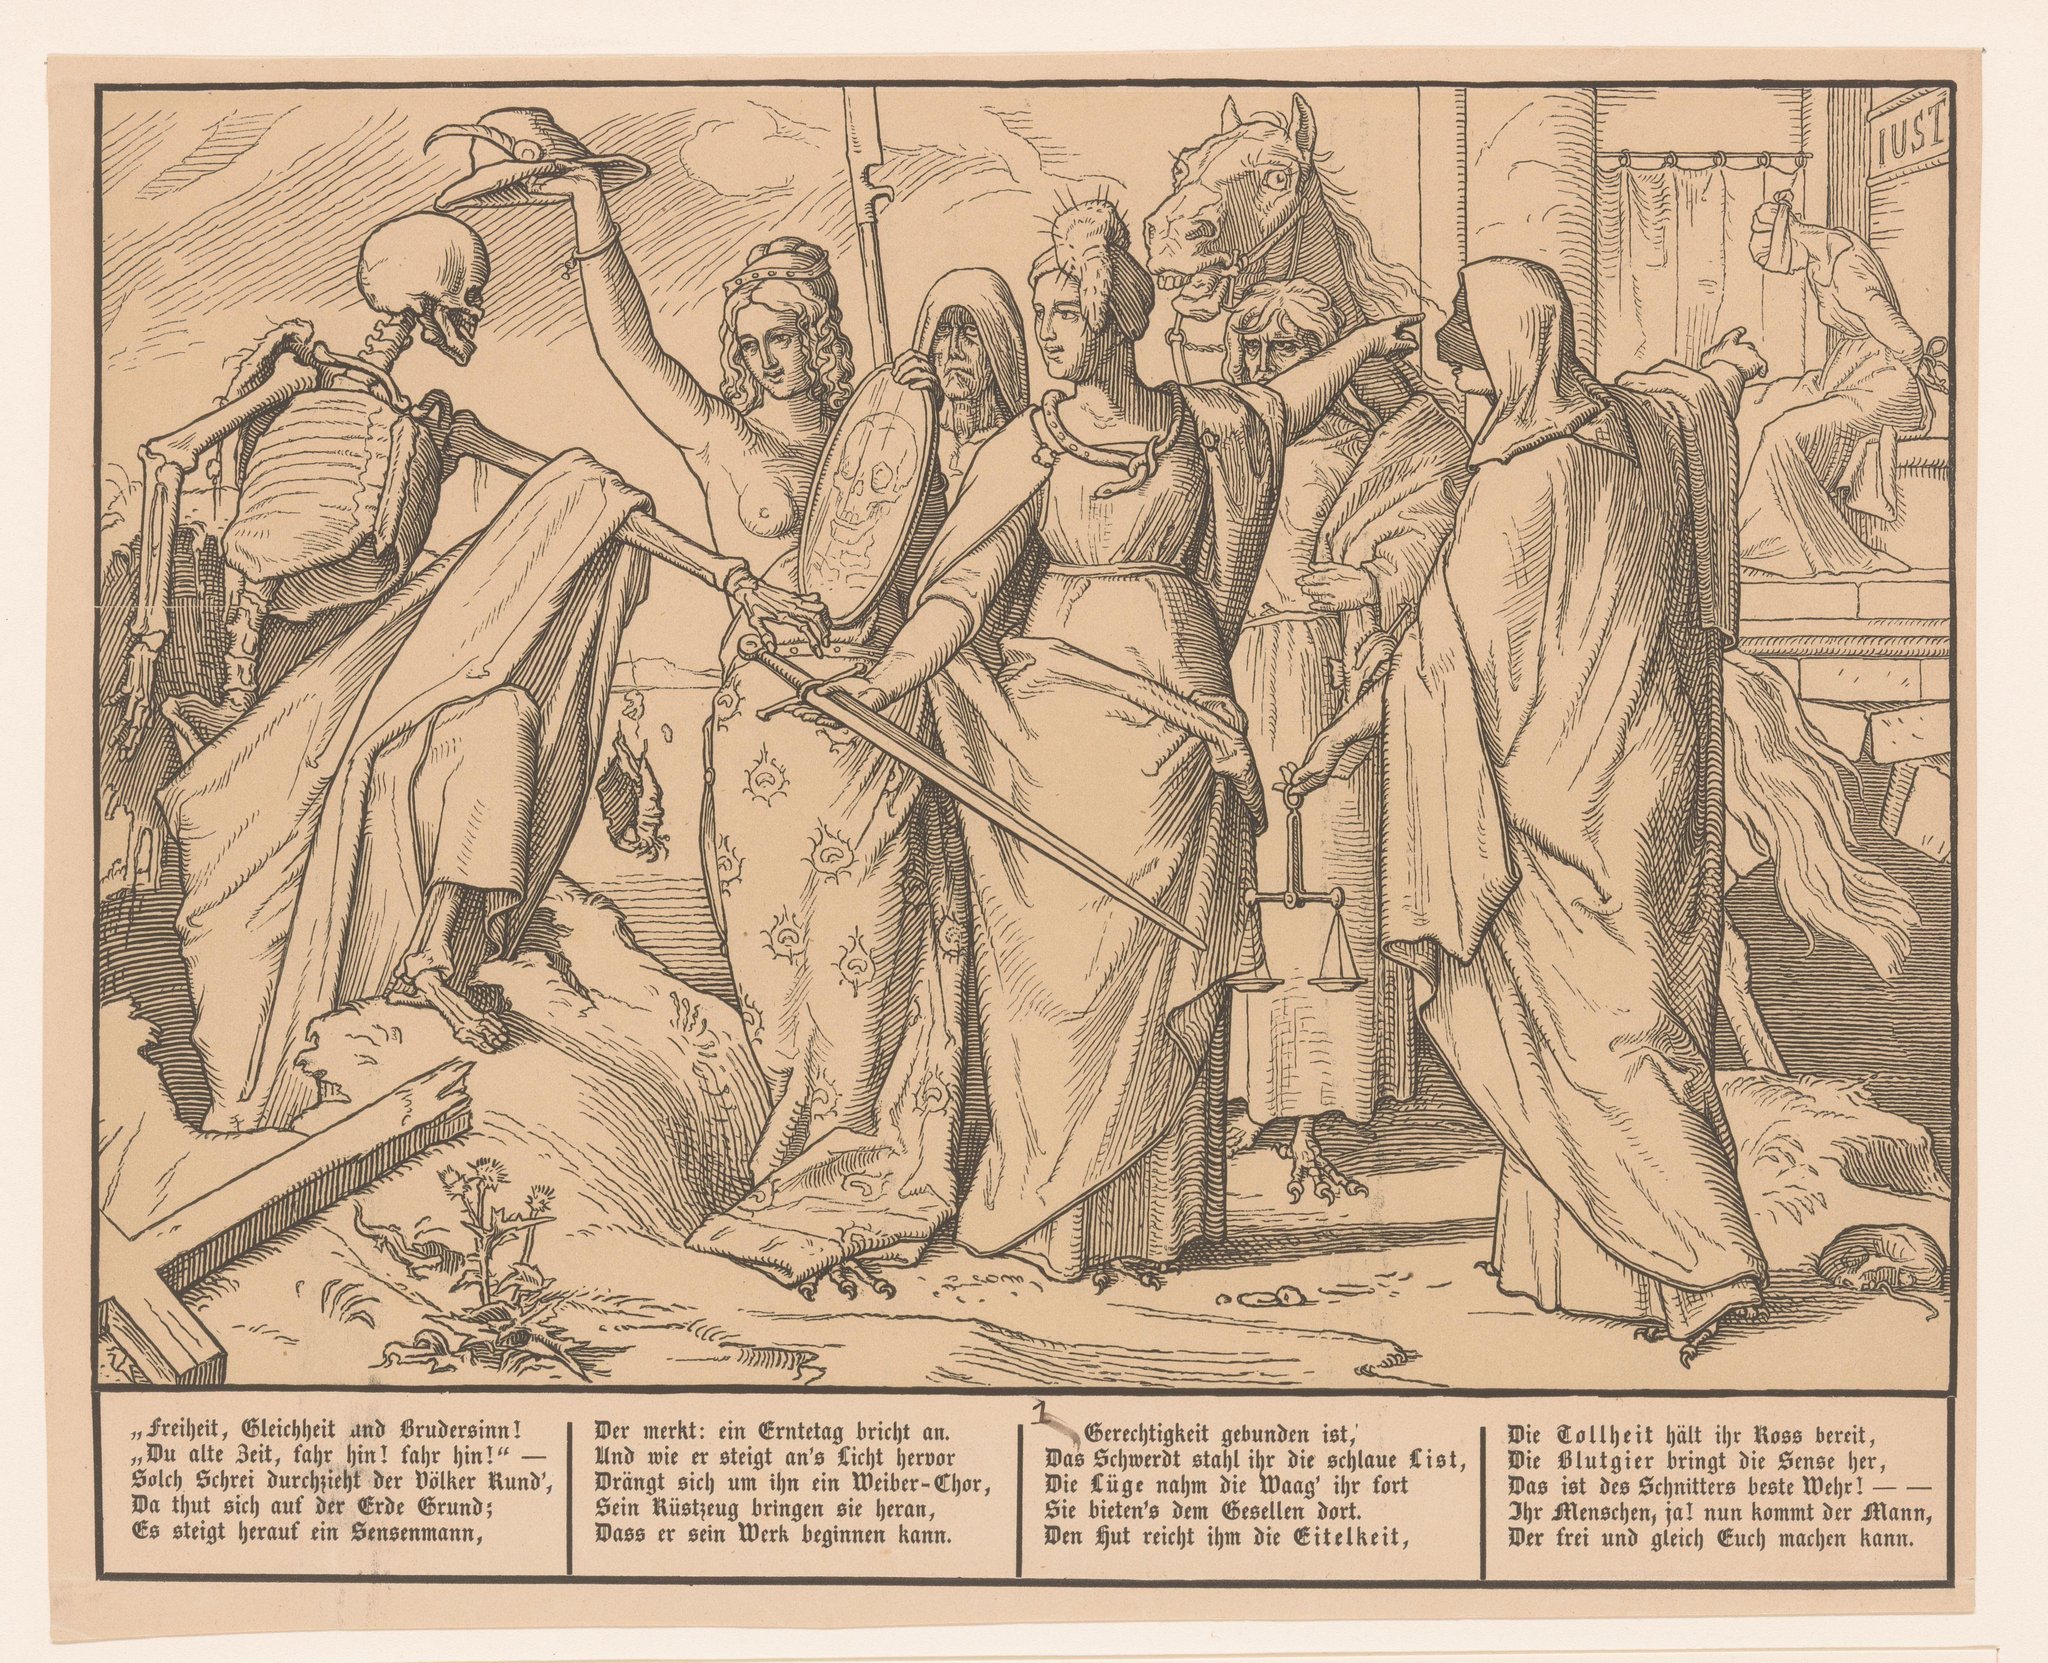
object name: print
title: Dood rijst op uit het graf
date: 1848-1849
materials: paper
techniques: woodcut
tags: dance of death; death together with one or more human beings, revolution, revolt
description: Allegorie op de revolutie in de Duitse landen van 1848: "Ein Totentanz aus dem Jahre 1848", Volksuitgave van Augustus.